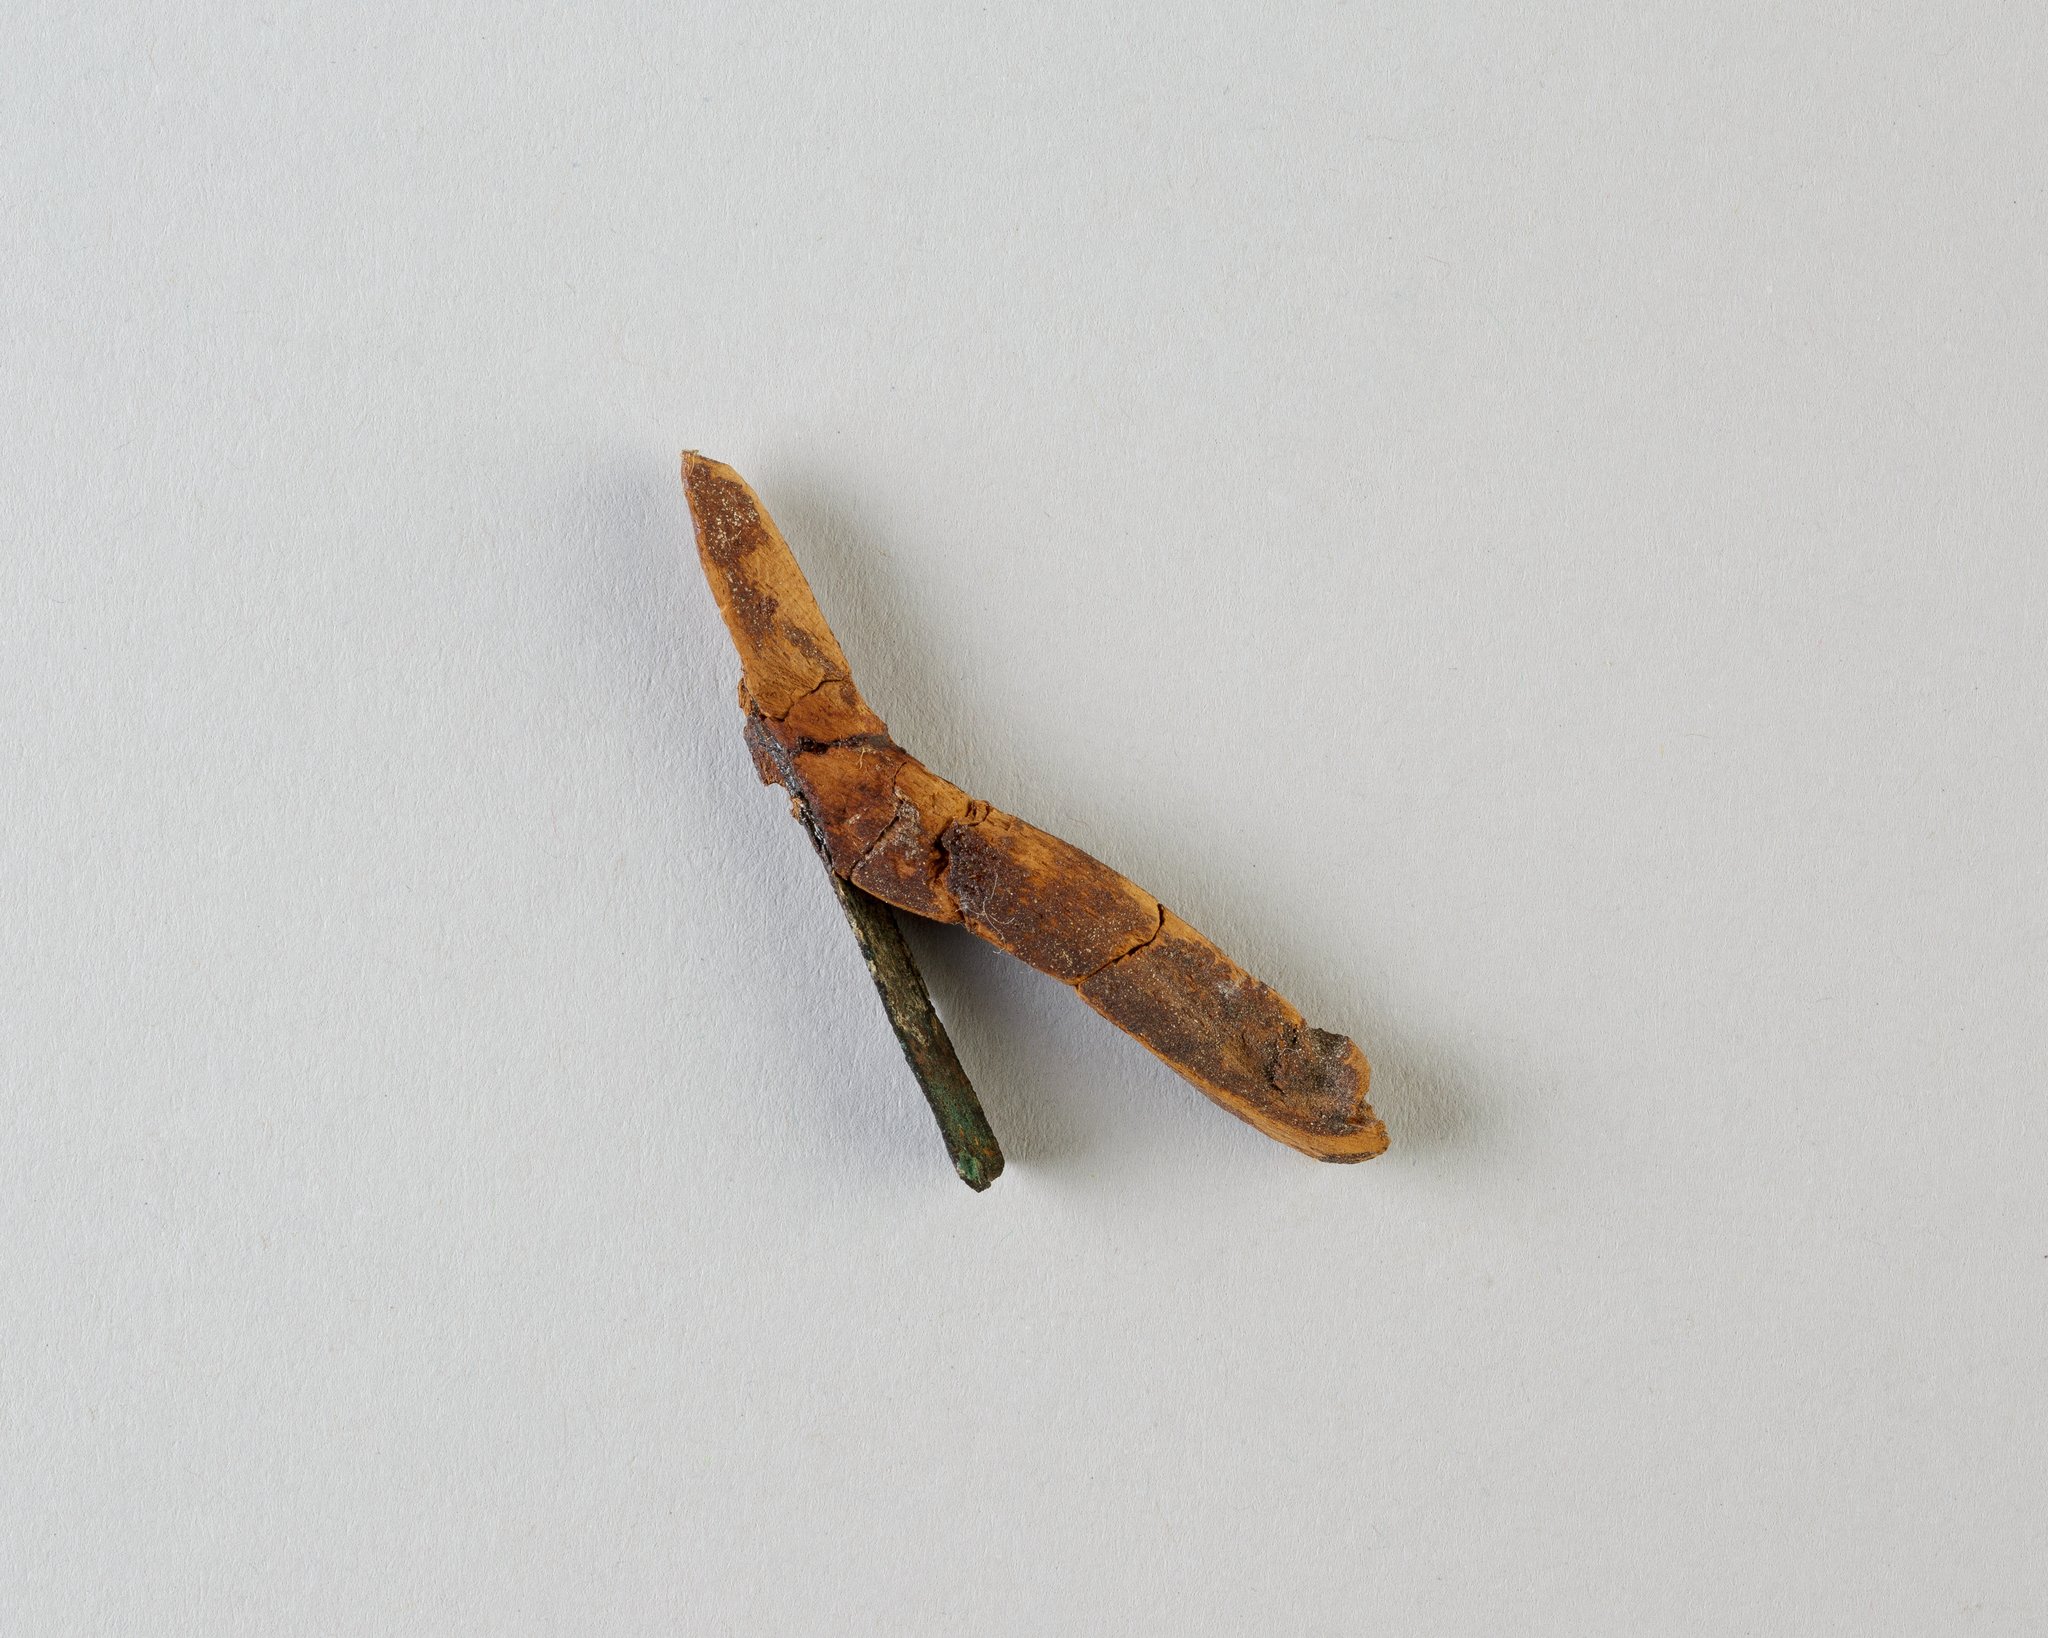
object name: adze, model, tool, senenmut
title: Model Adze from a Foundation Deposit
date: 1479-1458 BCE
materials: bronze, copper alloy, wood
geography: egypt